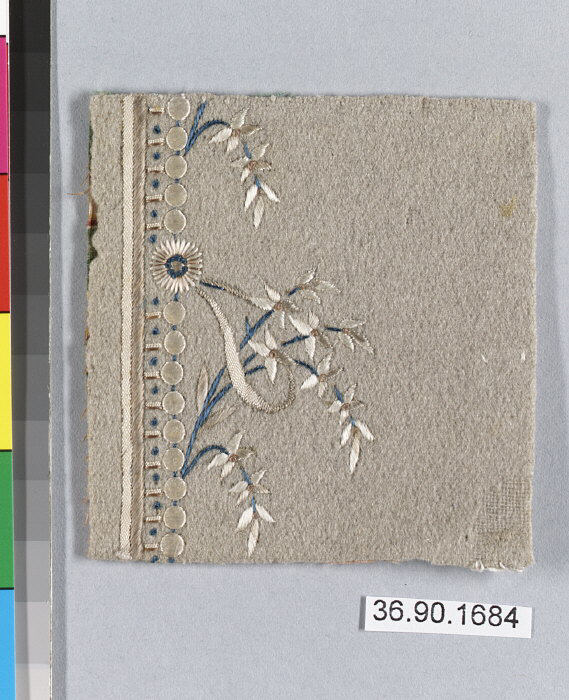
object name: sample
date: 1801-1833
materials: felt, silk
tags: flowers